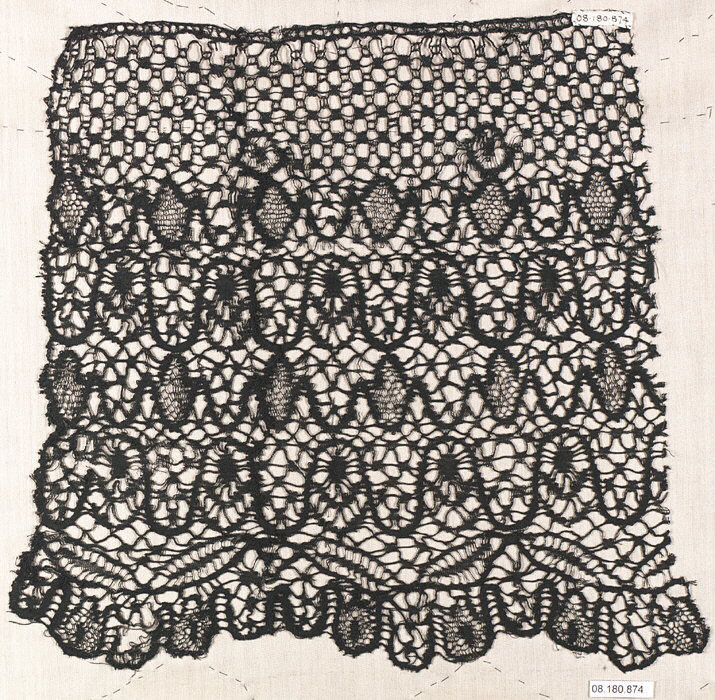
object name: fragment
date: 1801-1900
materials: lace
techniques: lace